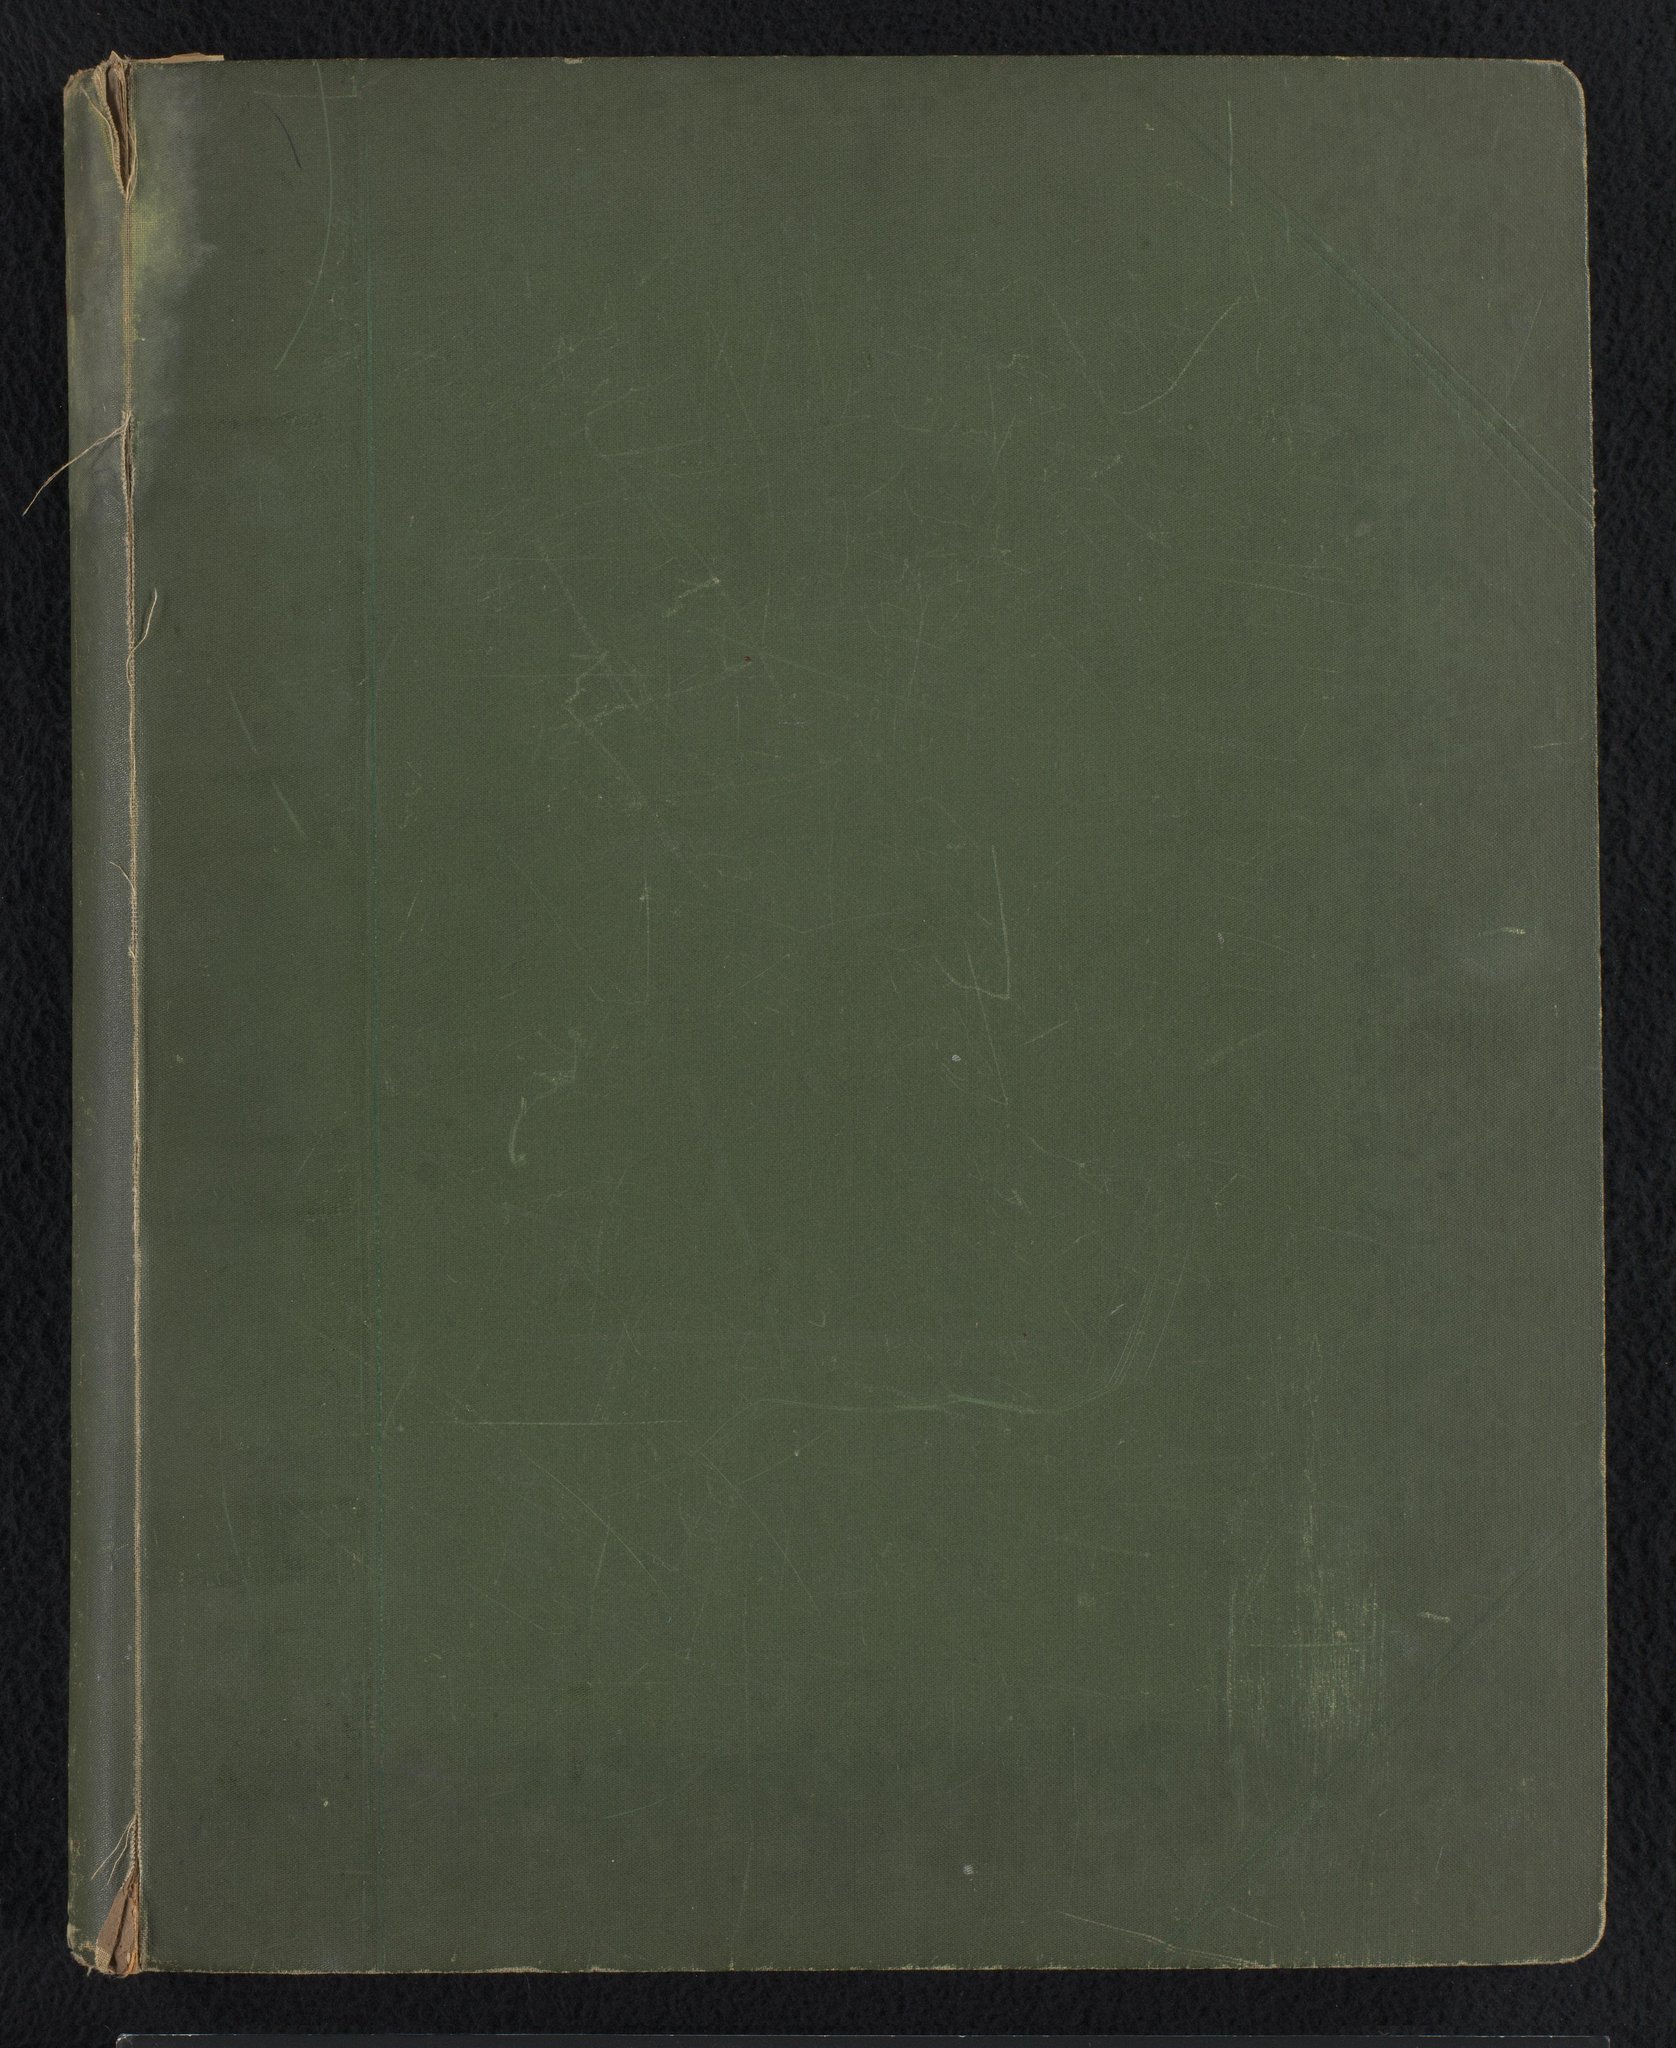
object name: photograph album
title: Franse voorwerpen als kroonluchters, bekleed met groen canvas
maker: Anonymous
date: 1860-1900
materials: canvas, cardboard, paper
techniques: various techniques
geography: netherlands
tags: applied arts, arts and crafts; industrial design, chandelier, candelabrum, furniture and household effects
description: Album met foto's van Franse voorwerpen als kroonluchters, bekleed met groen canvas. Onderdeel van een serie met betrekking tot het interieur van het paleis van Versailles met kroonluchters, deuren, portalen en meubelstukken.